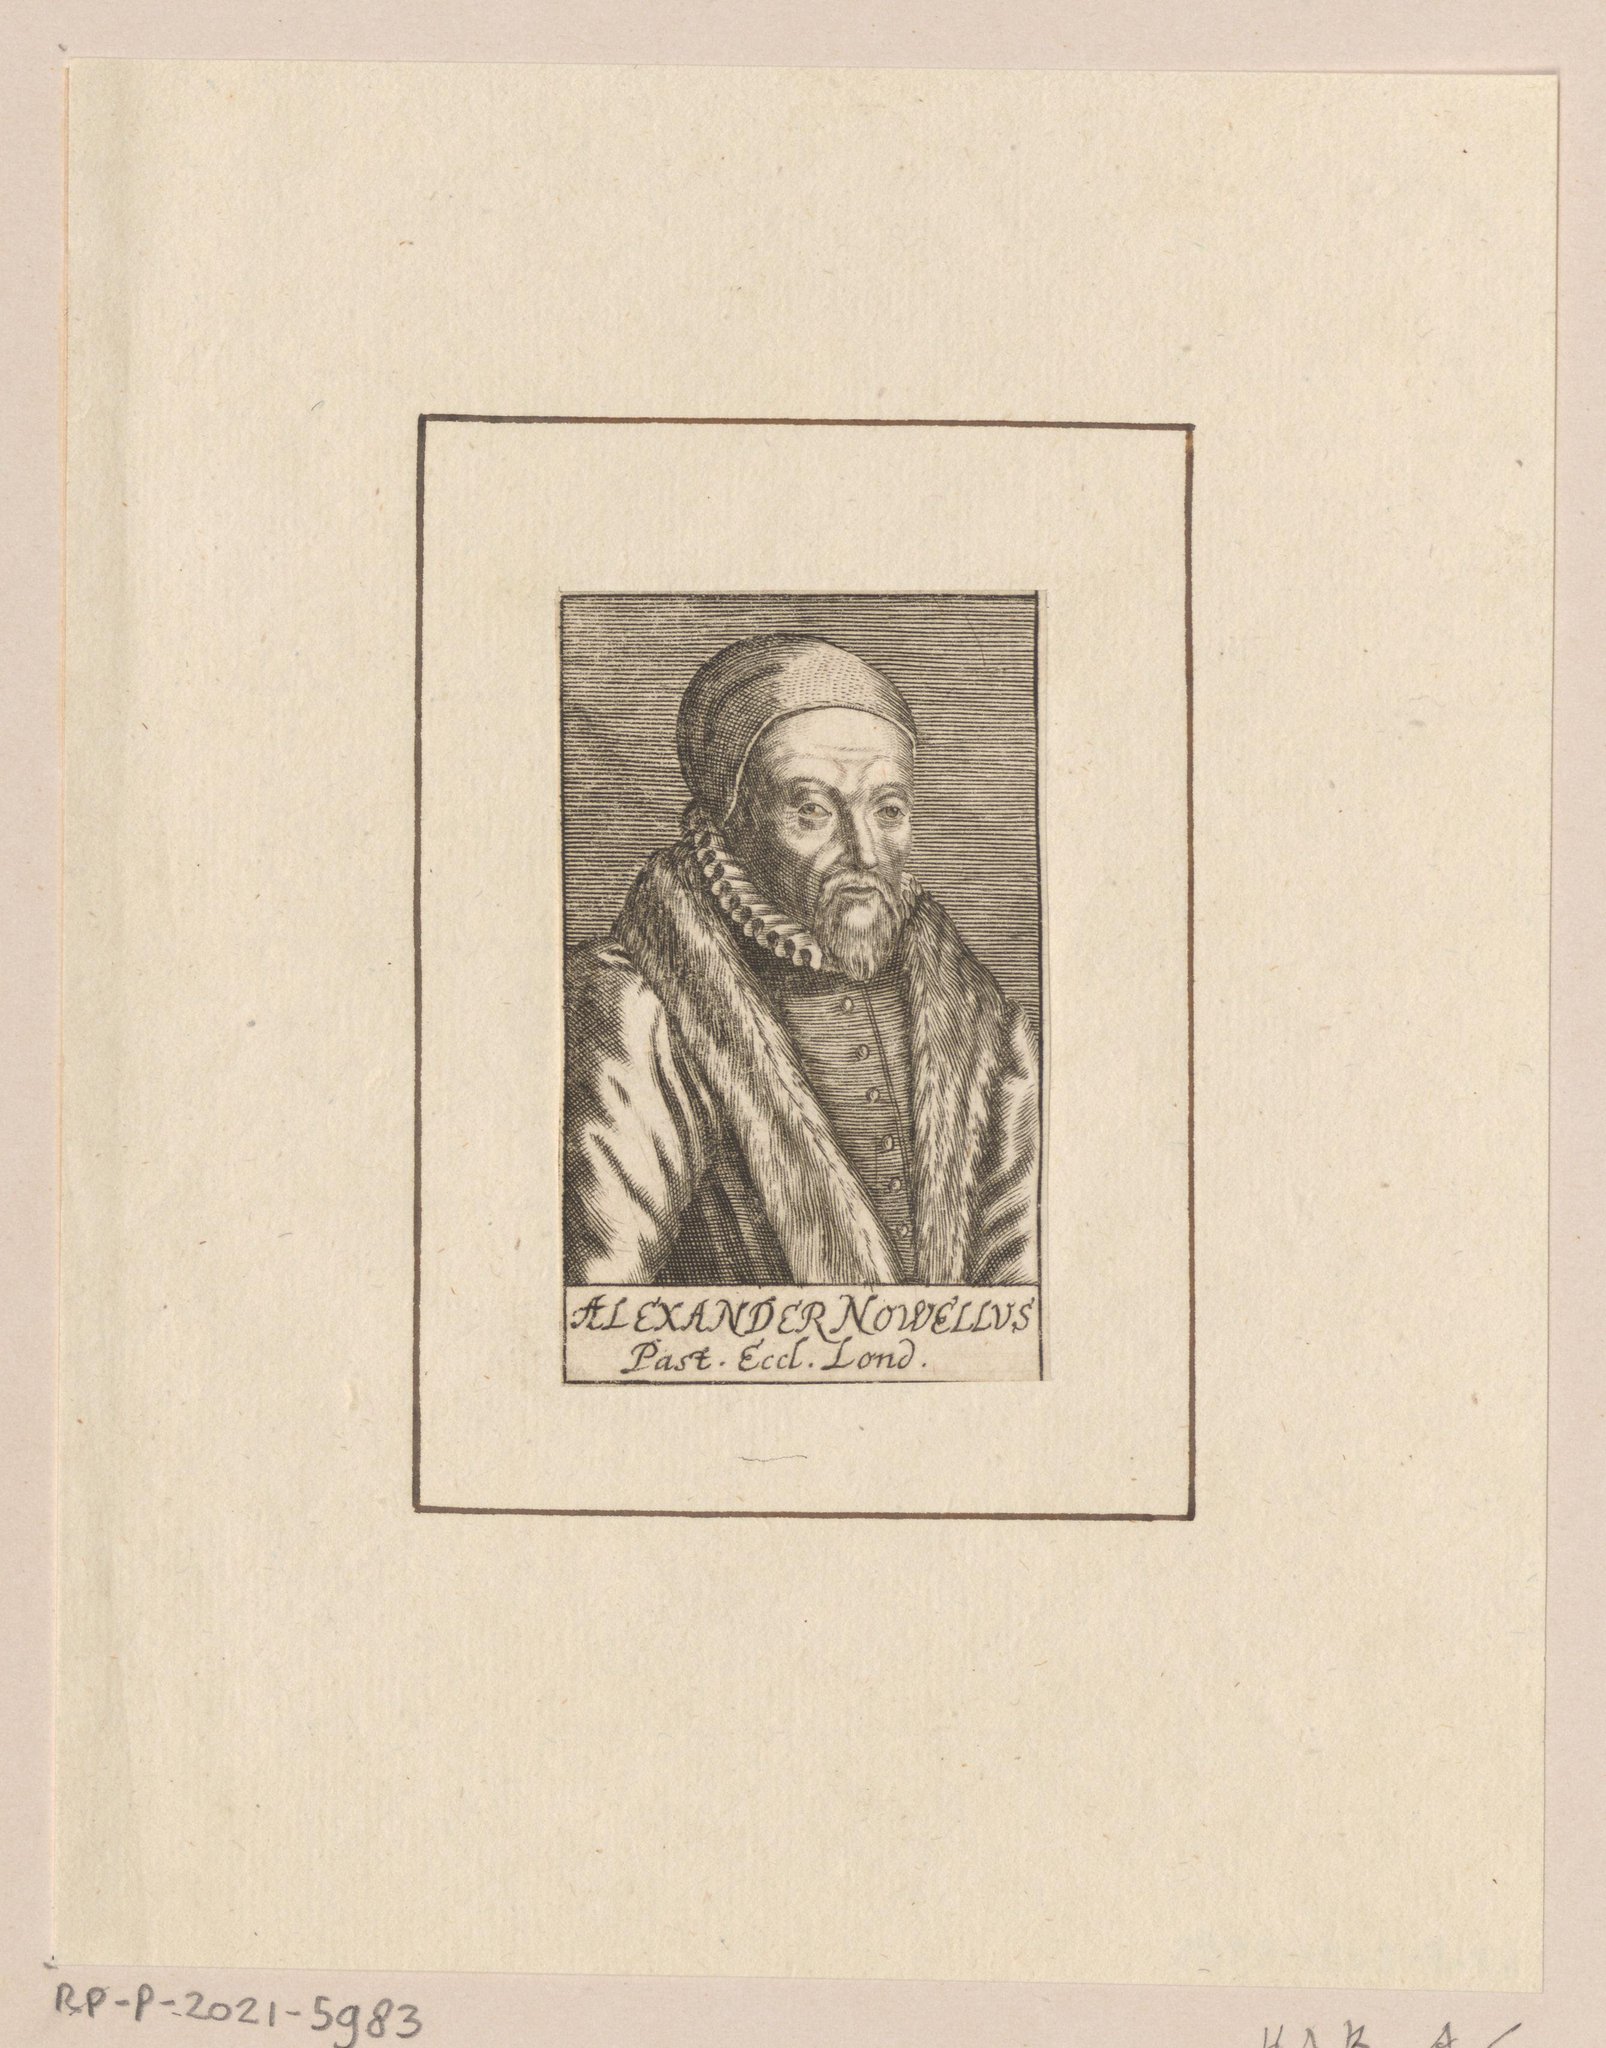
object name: print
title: Portret van Alexander Nowell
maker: Anonymous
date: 1688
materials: paper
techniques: engraving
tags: theologian, historical persons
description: Prent maakt deel uit van een grotere prent die later is verknipt. Prent waarschijnlijk uit: Freher, Paul. Theatrum virorum eruditione clarorum. Neurenberg: Johann Hoffmann, 1688.